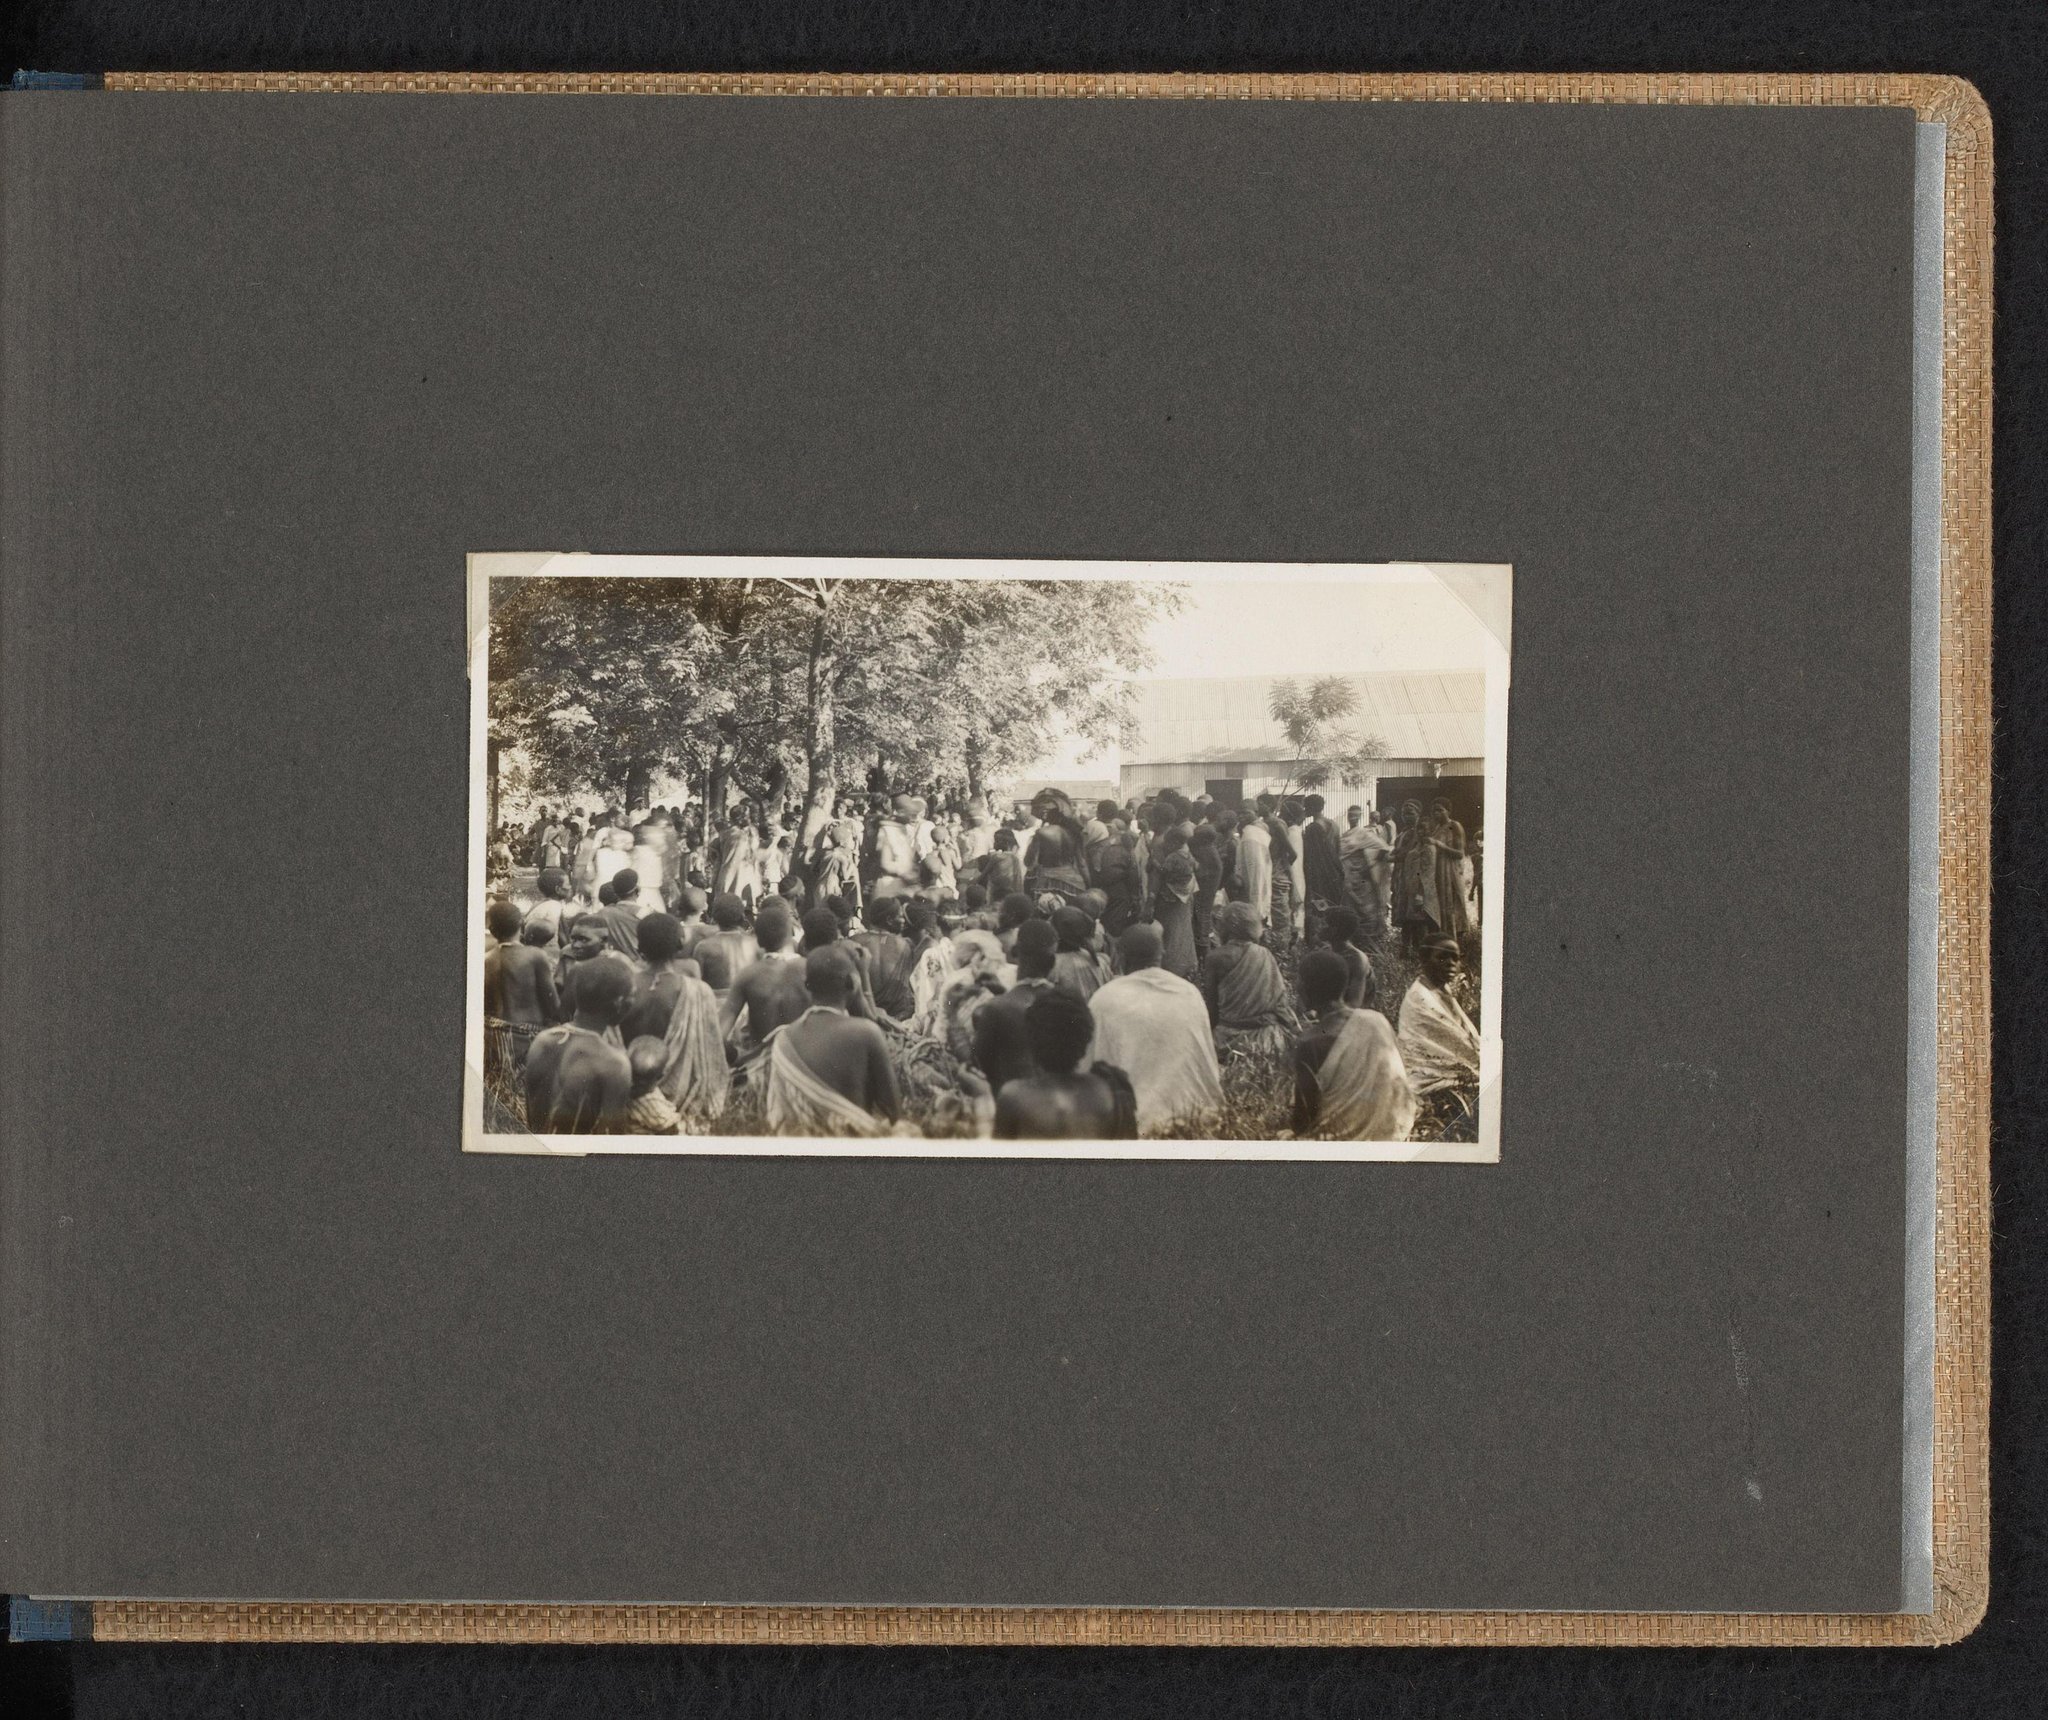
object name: album leaf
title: Bijeenkomst in Zuid-Afrika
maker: karel frederik van den berg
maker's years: 1873-1948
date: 1920-1930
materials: paper, cardboard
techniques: gelatin silver print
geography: south africa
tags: meeting